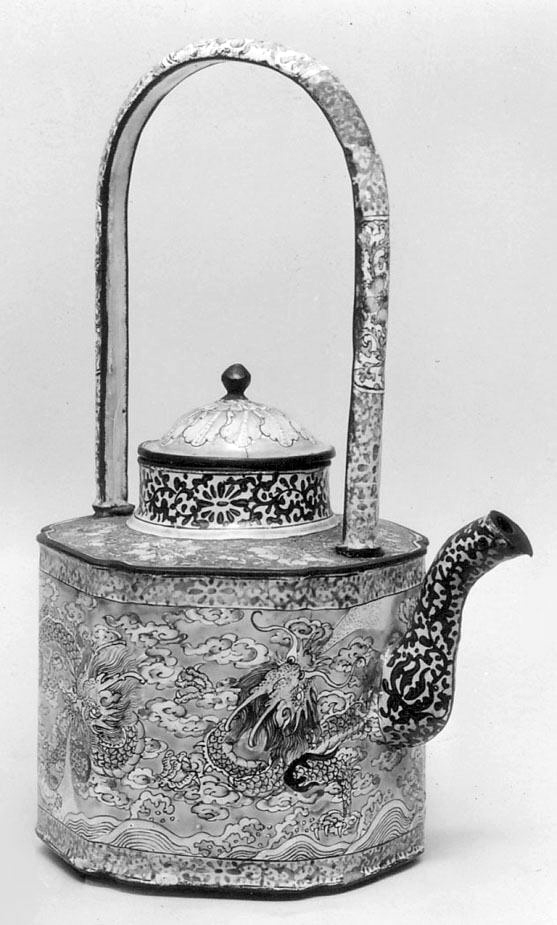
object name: covered wine pot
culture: chinese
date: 1736-1795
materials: enamel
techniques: painting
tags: dragons